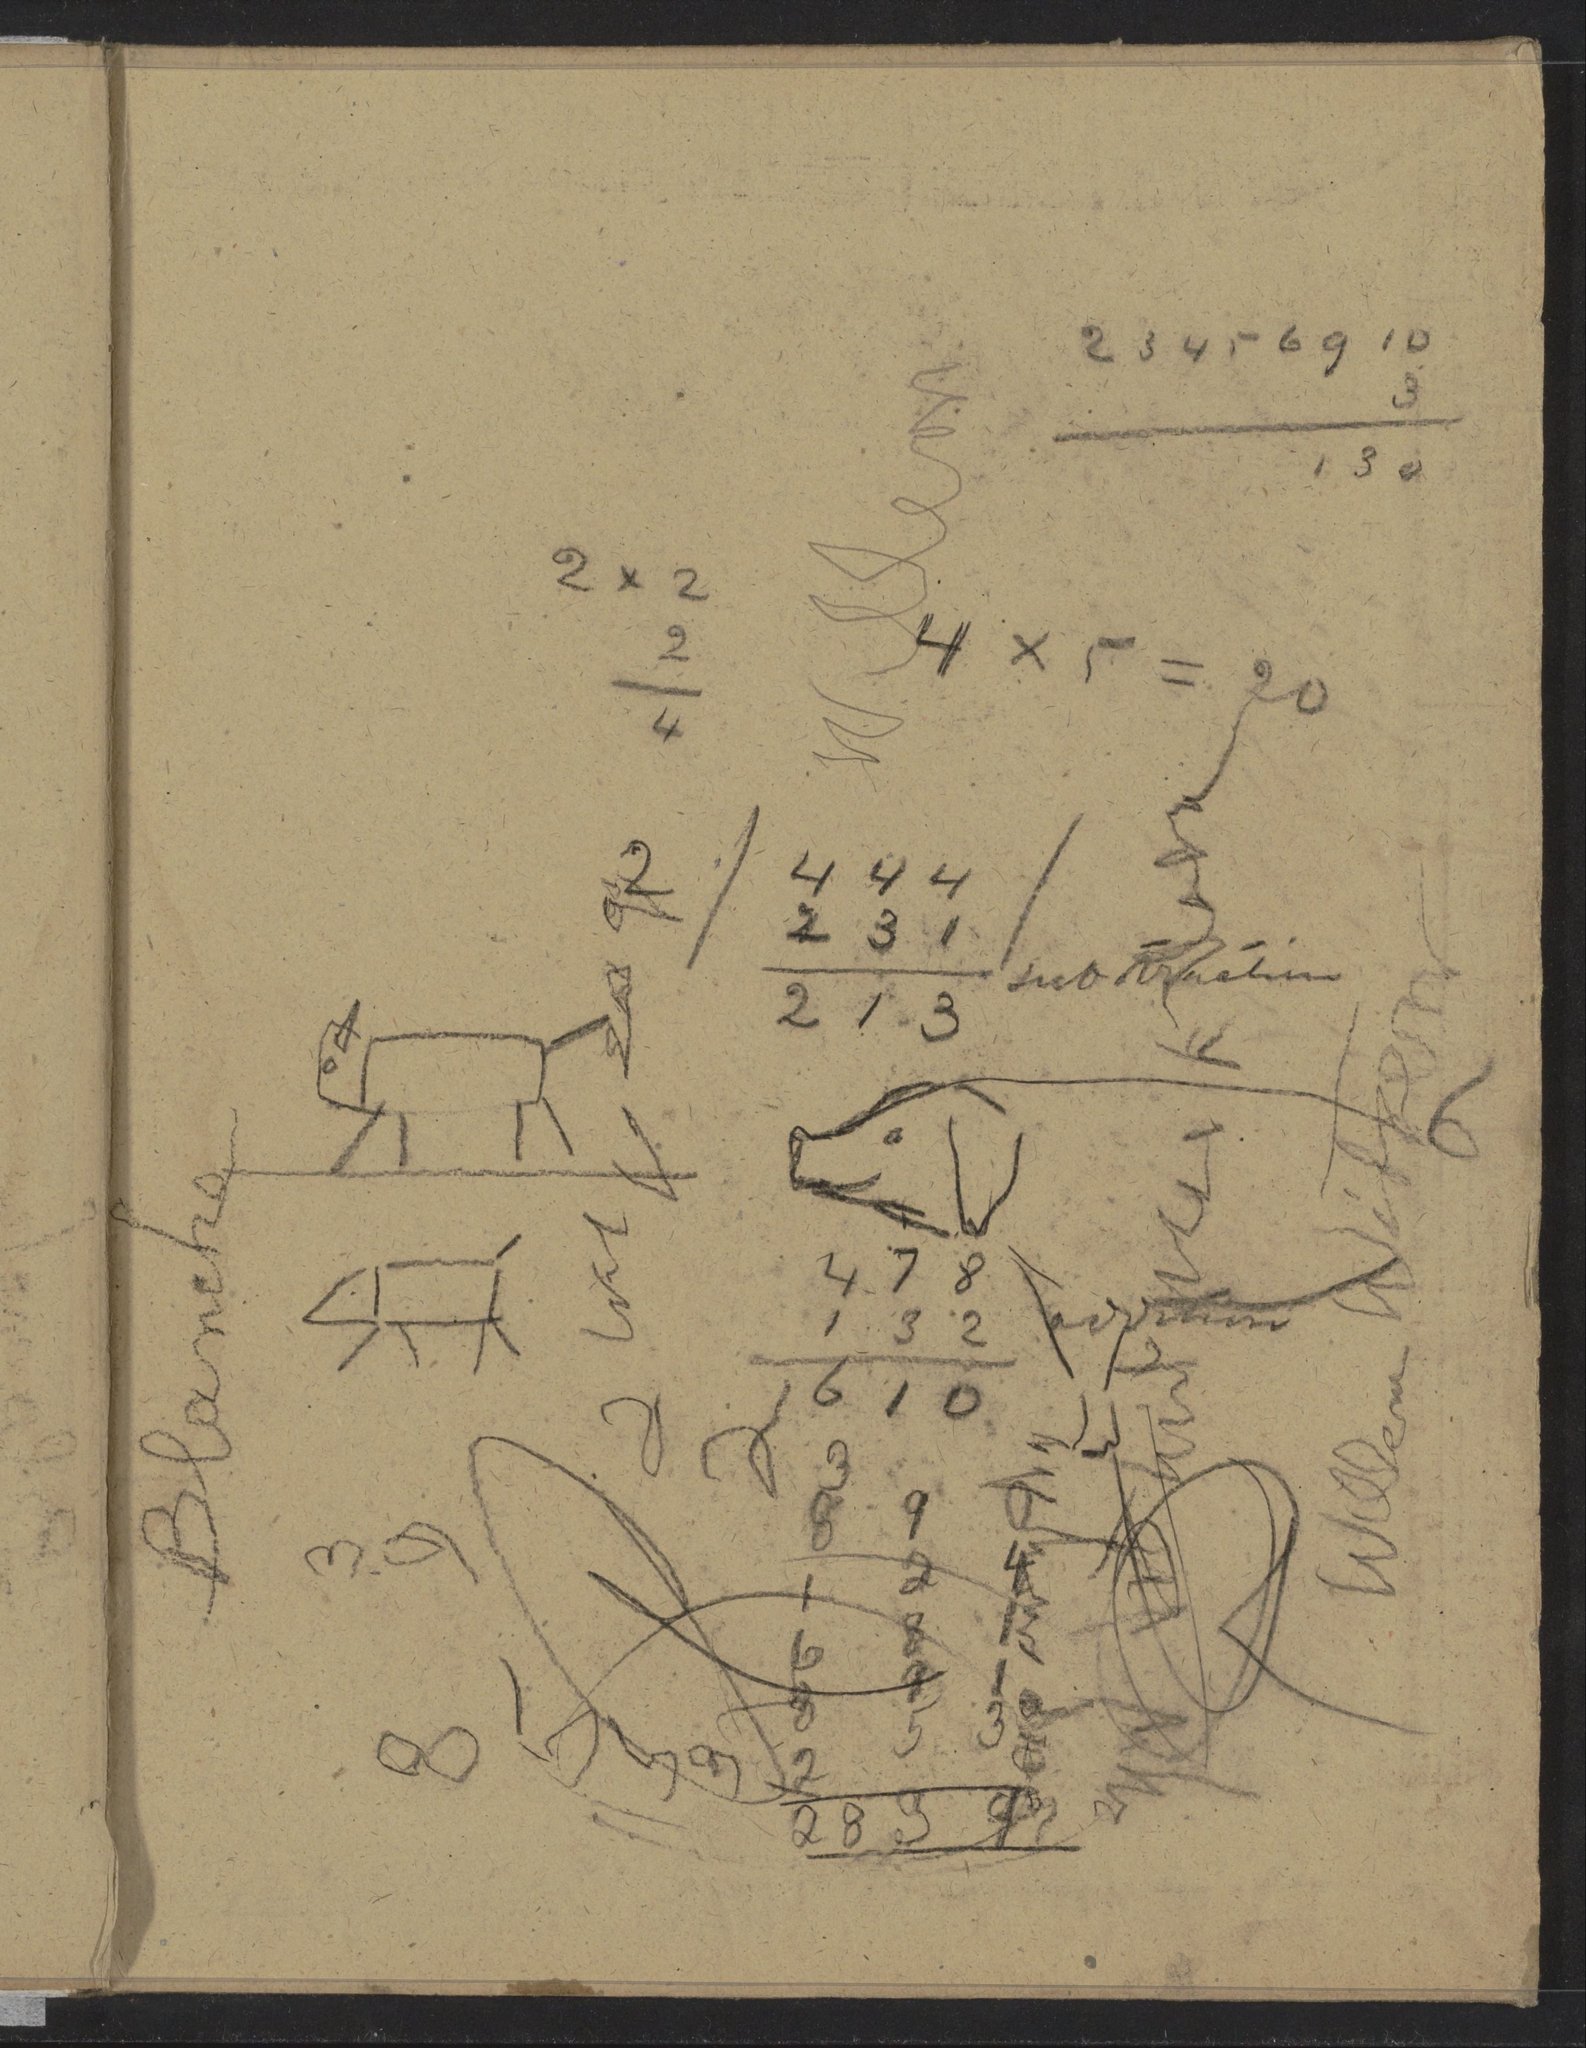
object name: sketchbook leaf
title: Studieblad met varkens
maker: willem witsen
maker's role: draughtsman, painter, print maker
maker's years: 1860-1923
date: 1887-1891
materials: chalk, paper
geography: amsterdam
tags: pig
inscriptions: annotation: ‘Blanche/ Willem/ Willem/ Willem Witsen’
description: Schutblad B, achterste schutblad, uit een schetsboek met 29 bladen.